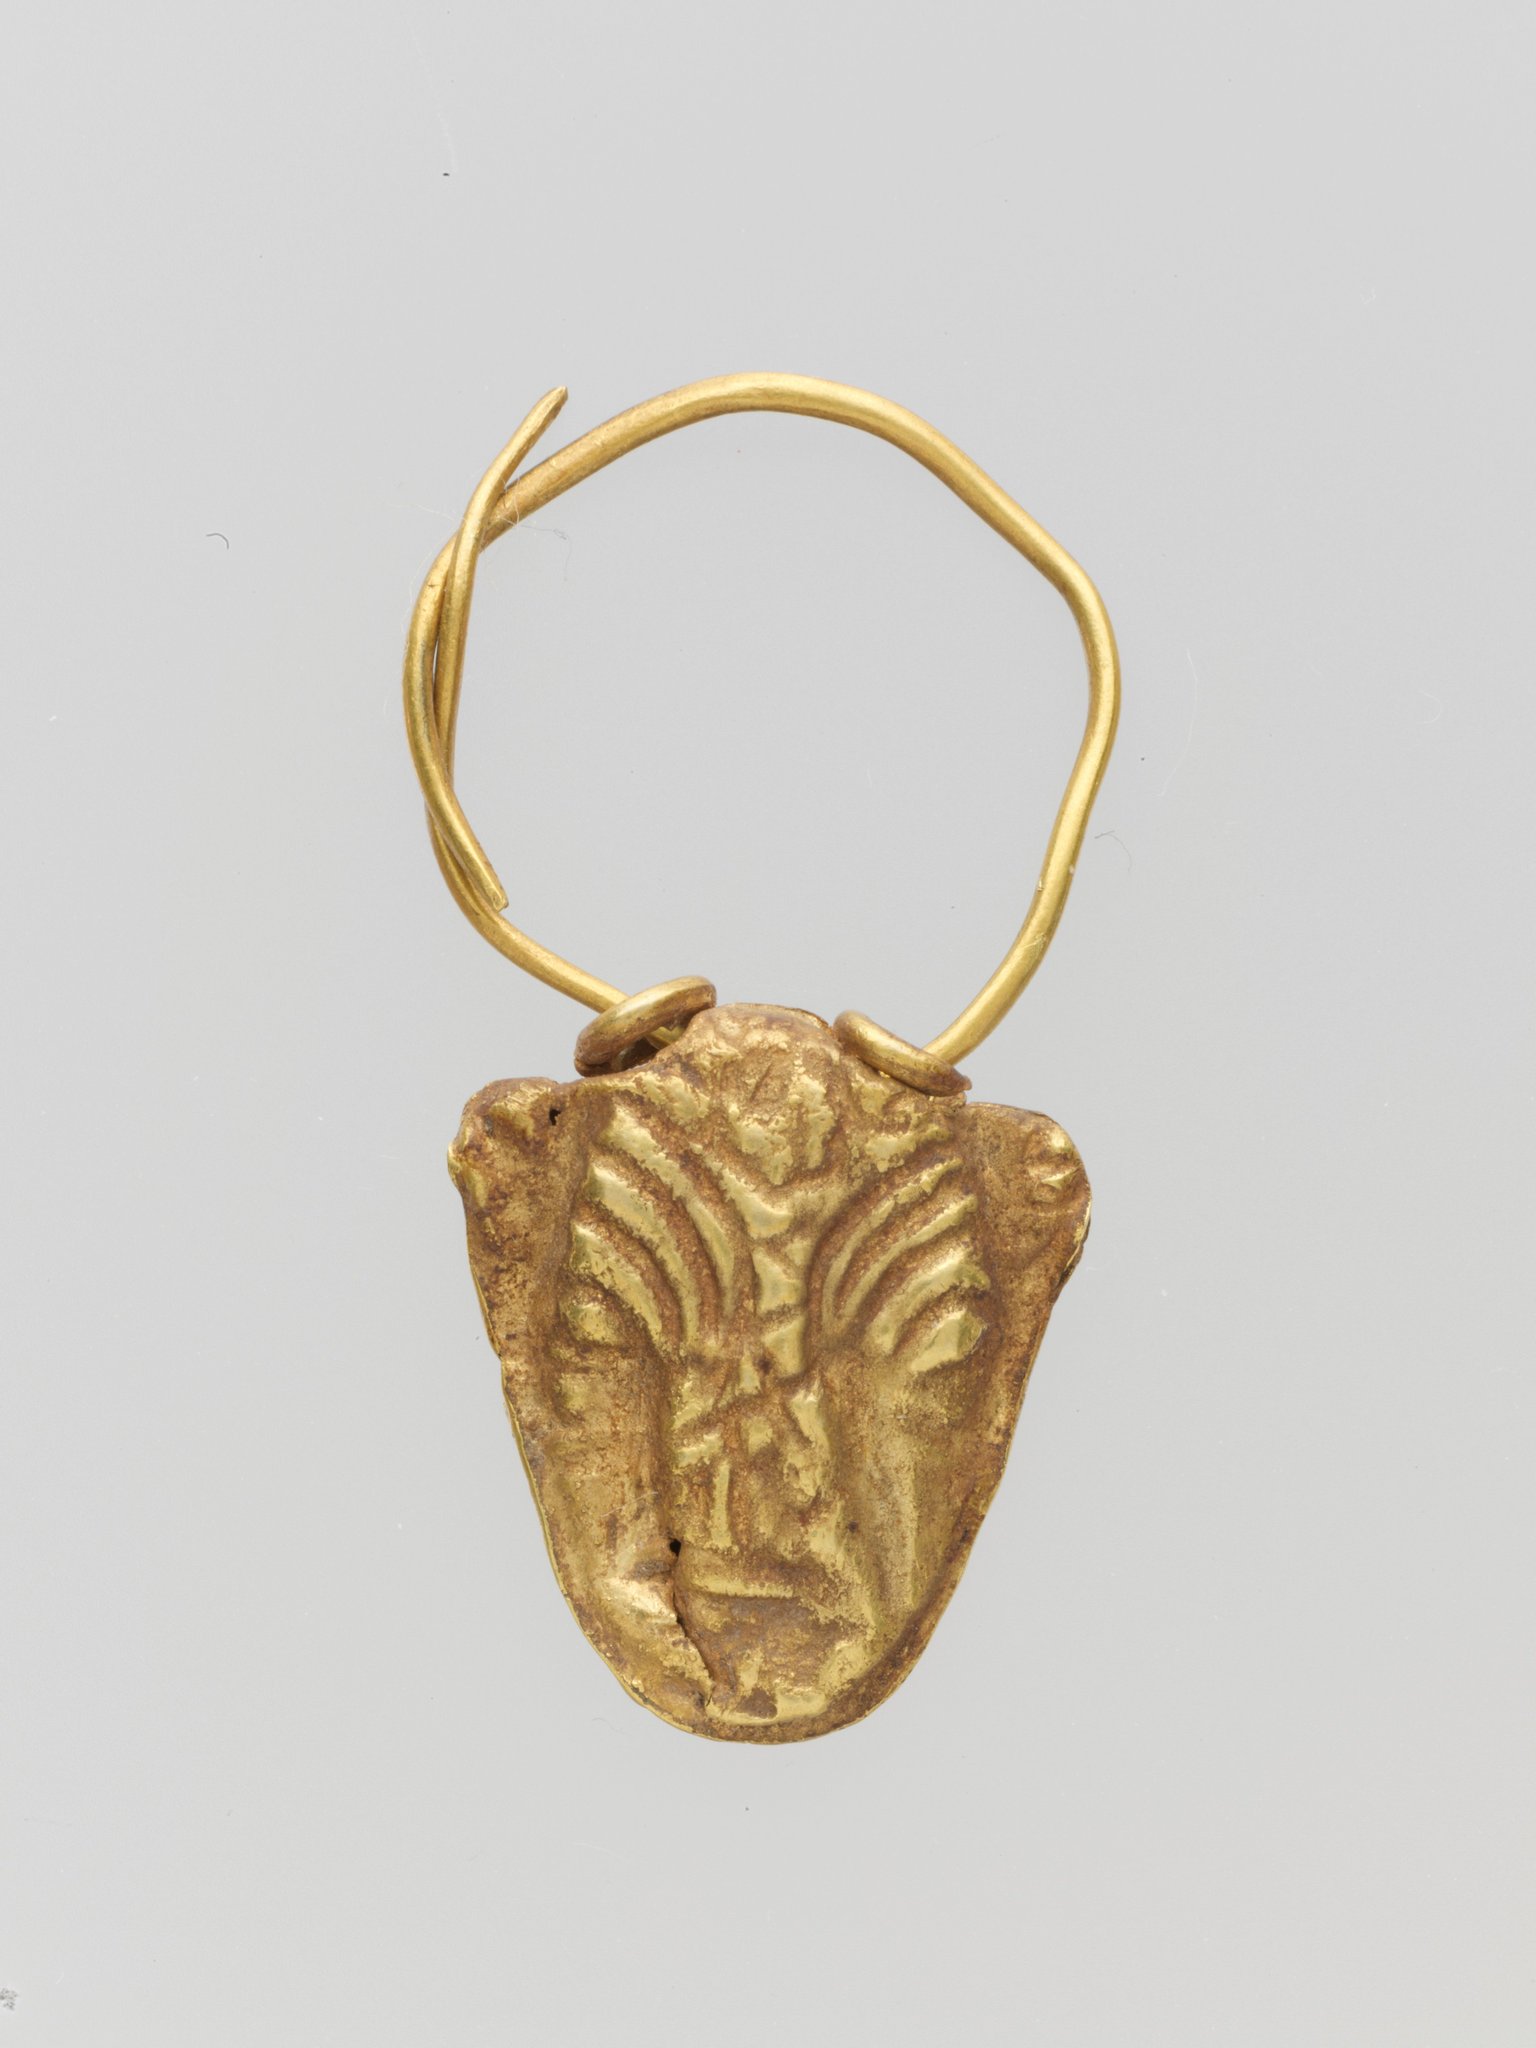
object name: earring with head of bull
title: Gold pendant in the form of a bull's head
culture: cypriot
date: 1400-1050 BCE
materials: gold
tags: bulls